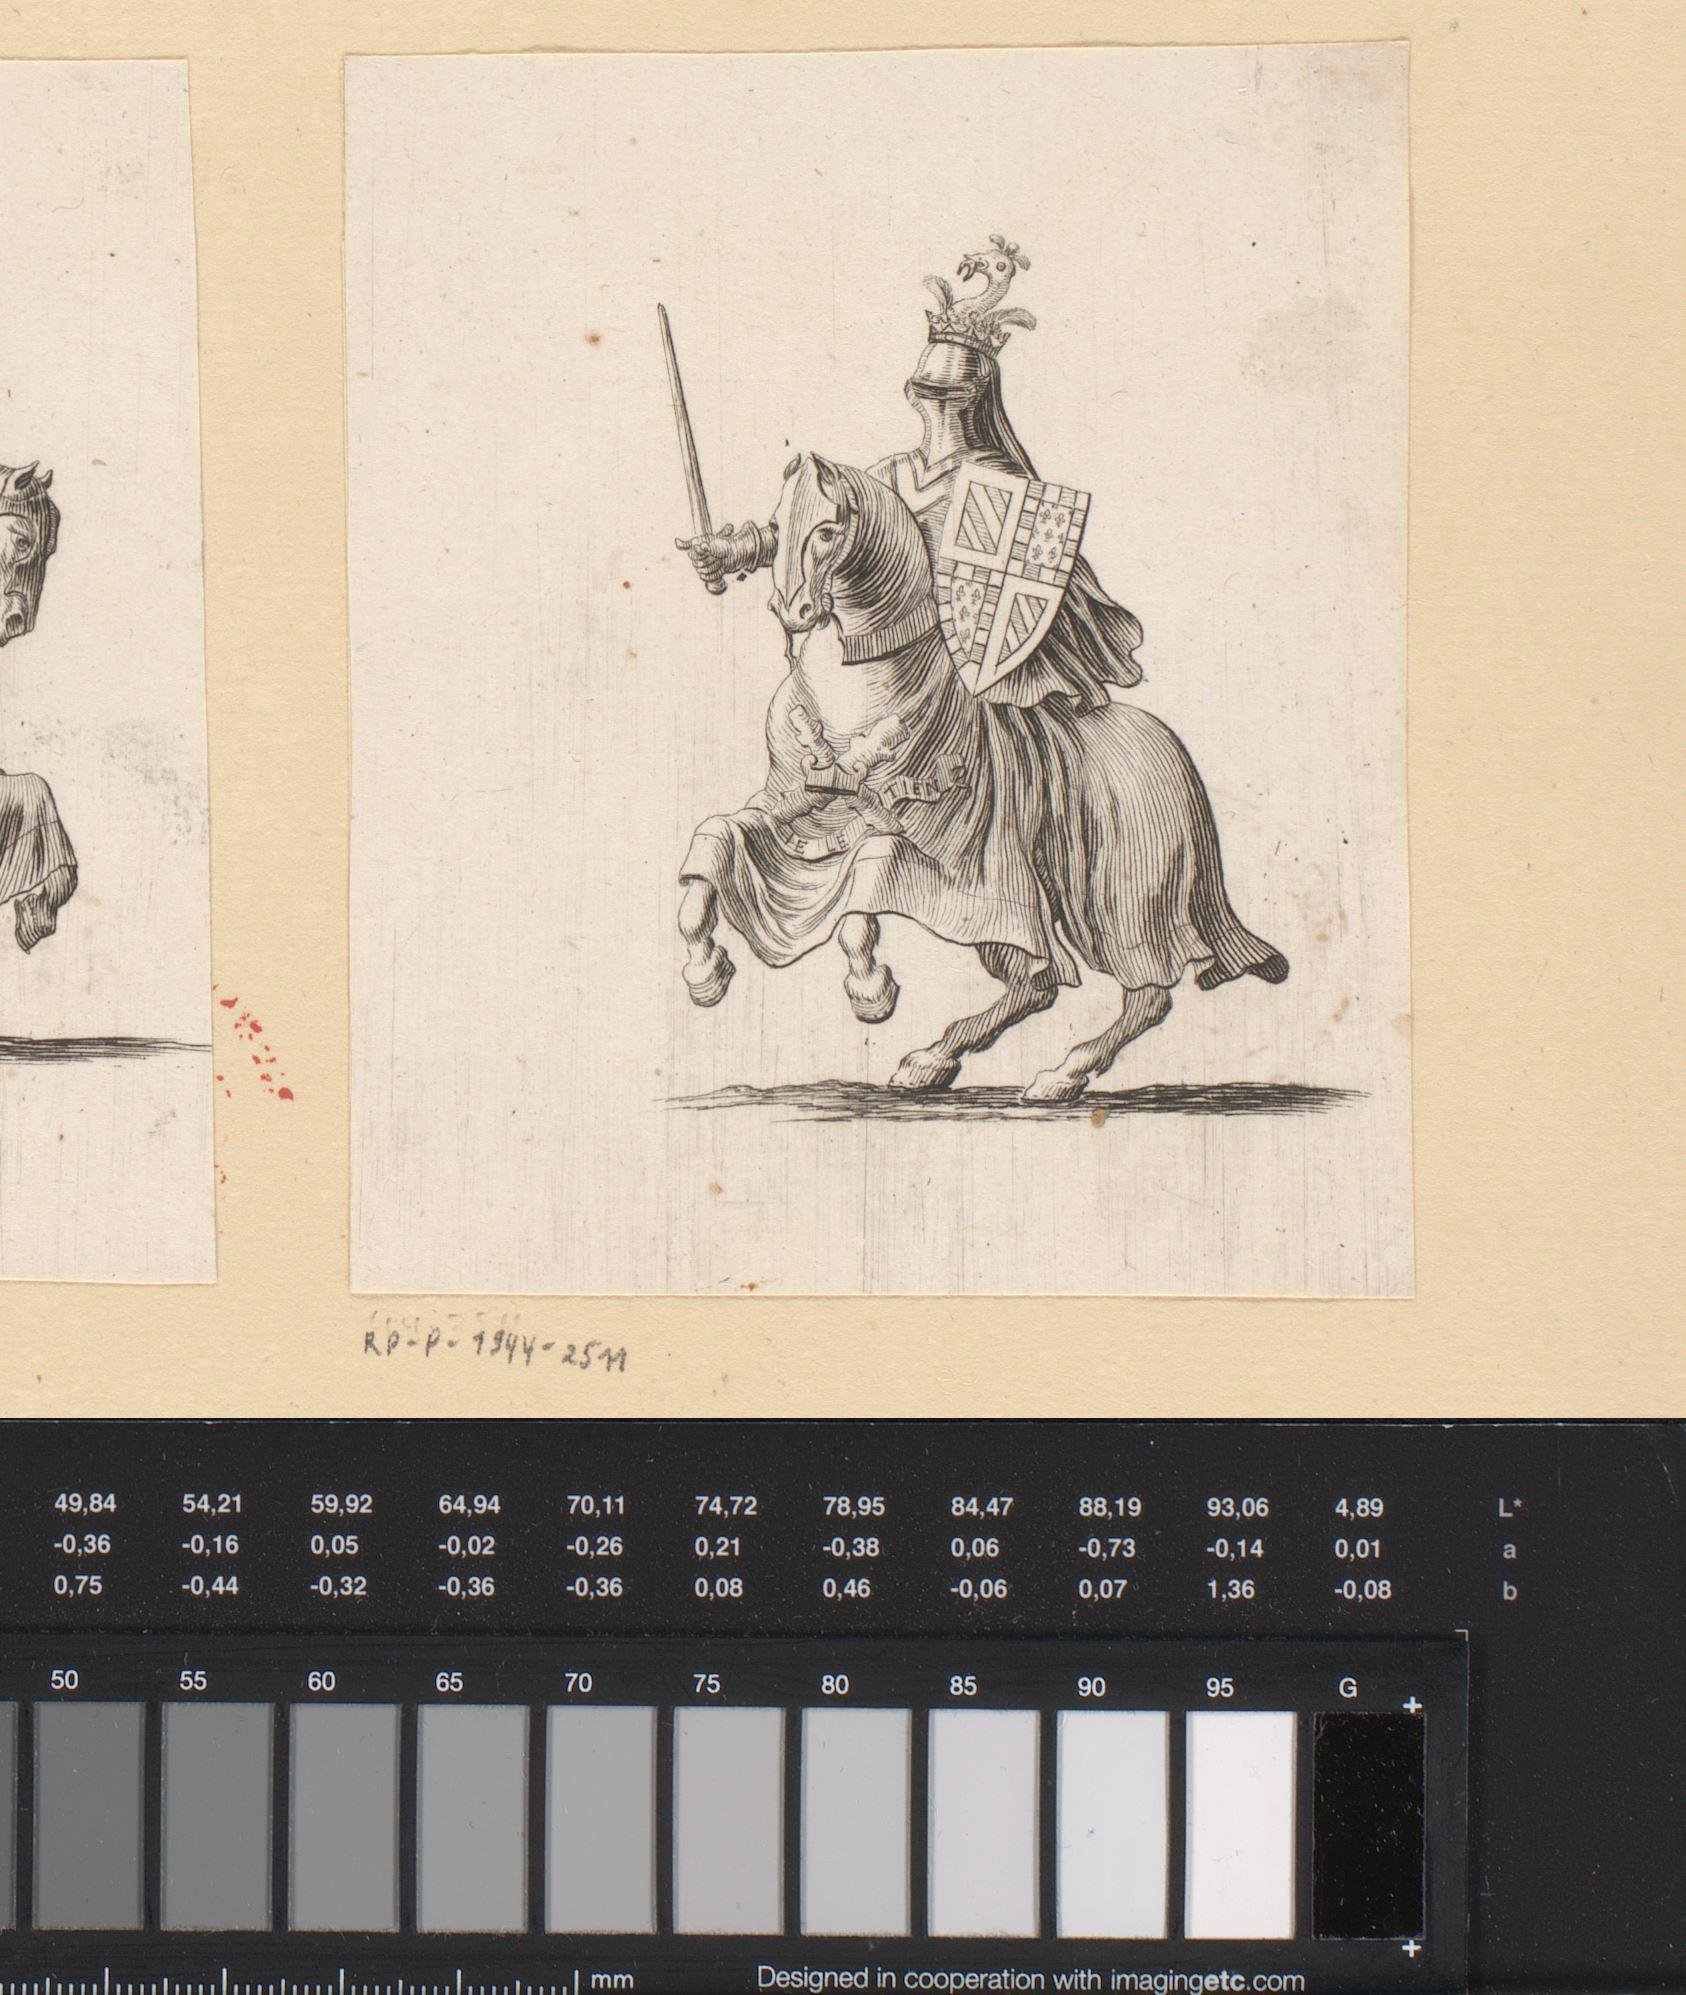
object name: print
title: Ridder te paard in wapenuitrusting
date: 1647-1714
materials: paper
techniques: engraving, etching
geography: france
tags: riding a horse, ass, or mule; rider, horseman, armour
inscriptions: collector's mark: Lugt 240